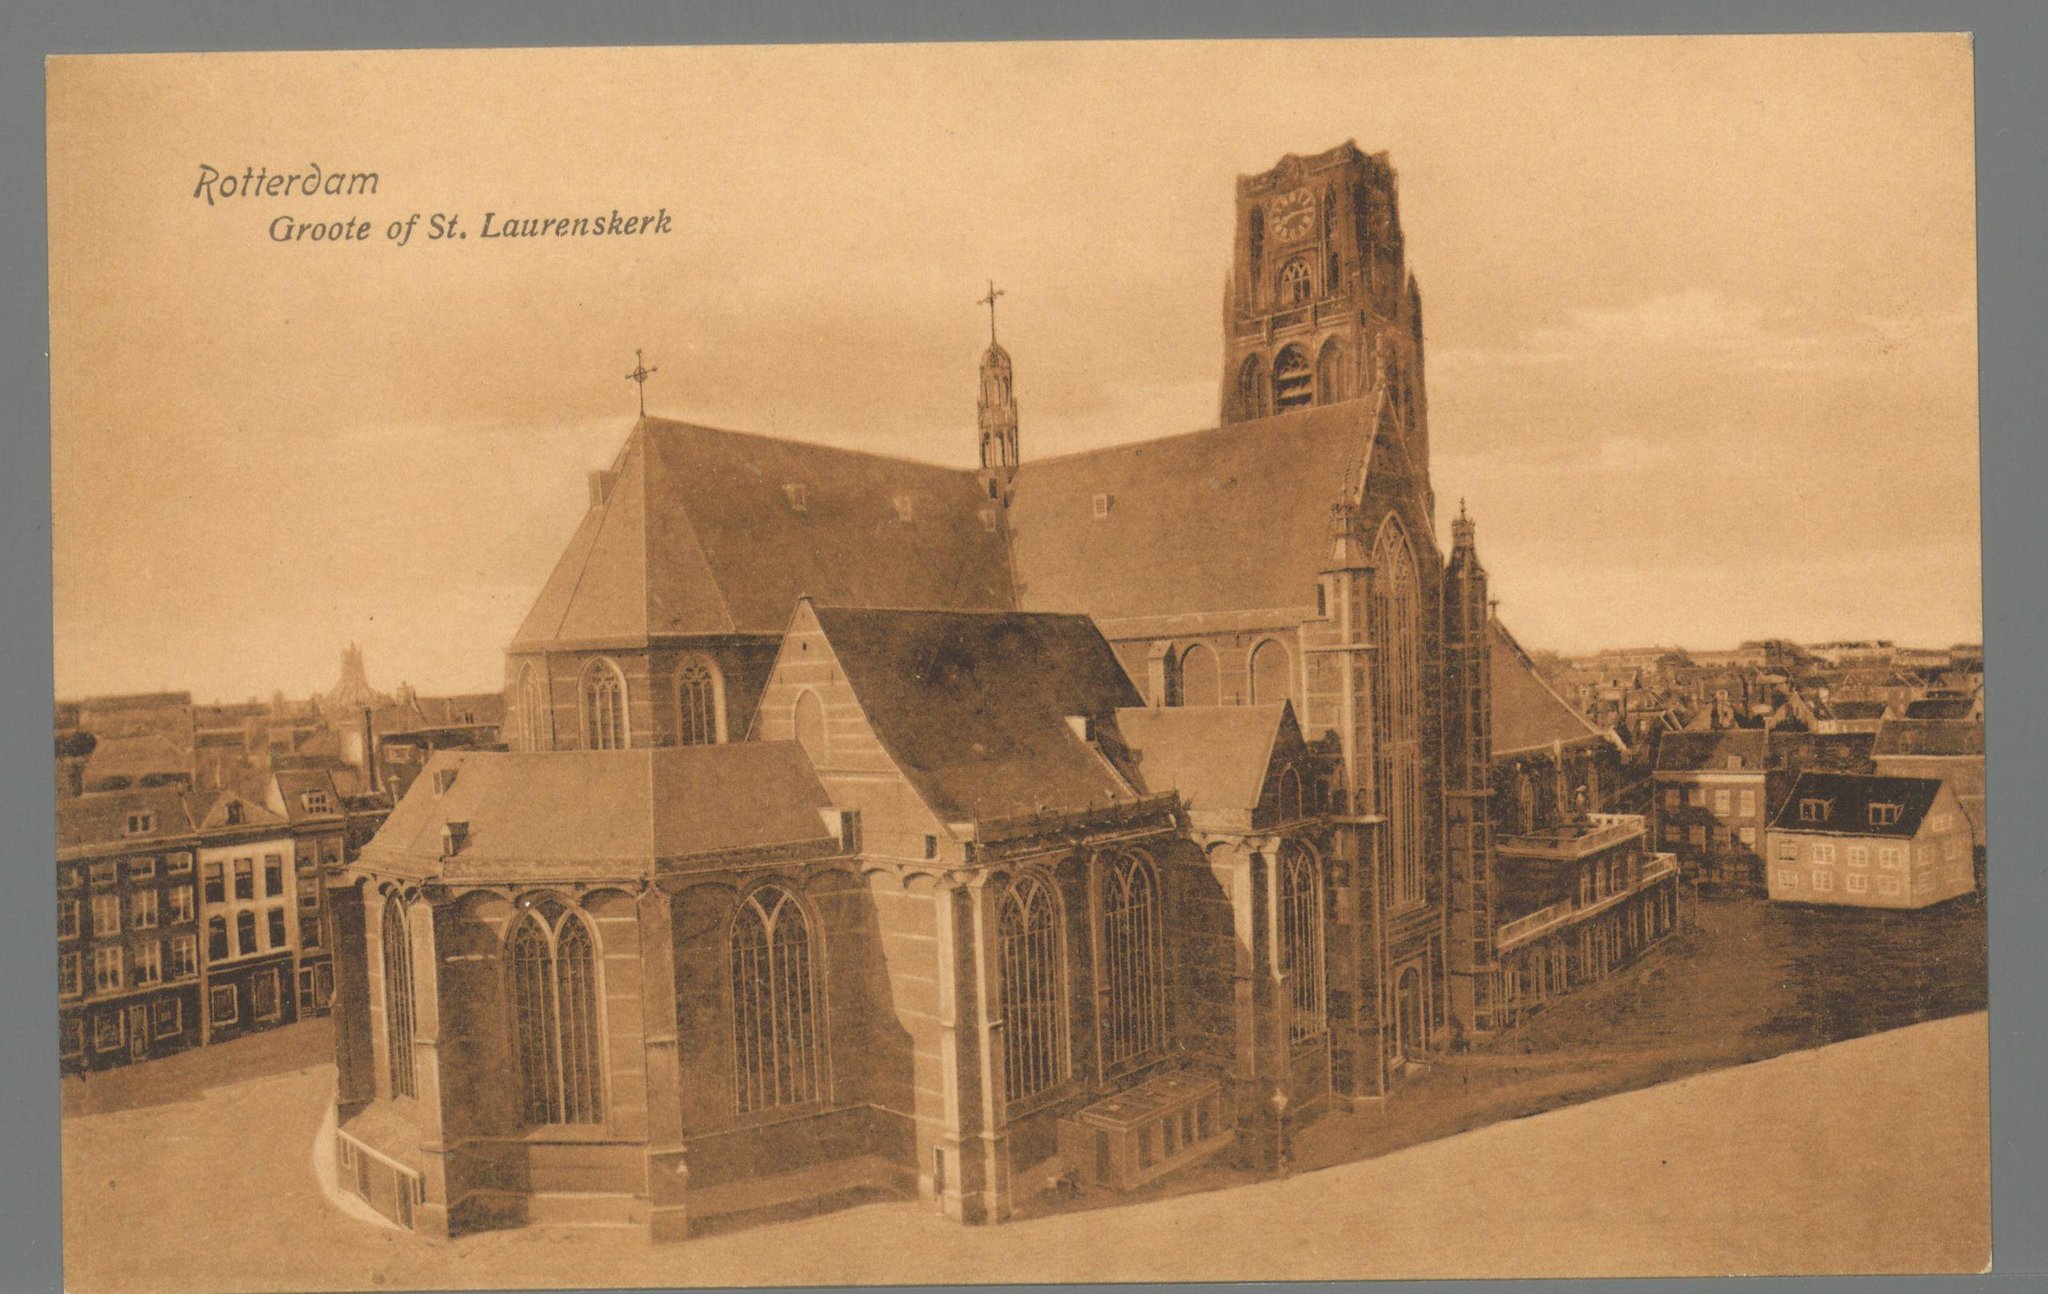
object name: photomechanical print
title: Rotterdam. Groote of St. Laurenskerk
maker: Anonymous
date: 1912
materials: cardboard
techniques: photograph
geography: the hague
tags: city-view, and landscape with man-made constructions, church (exterior)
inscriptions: date